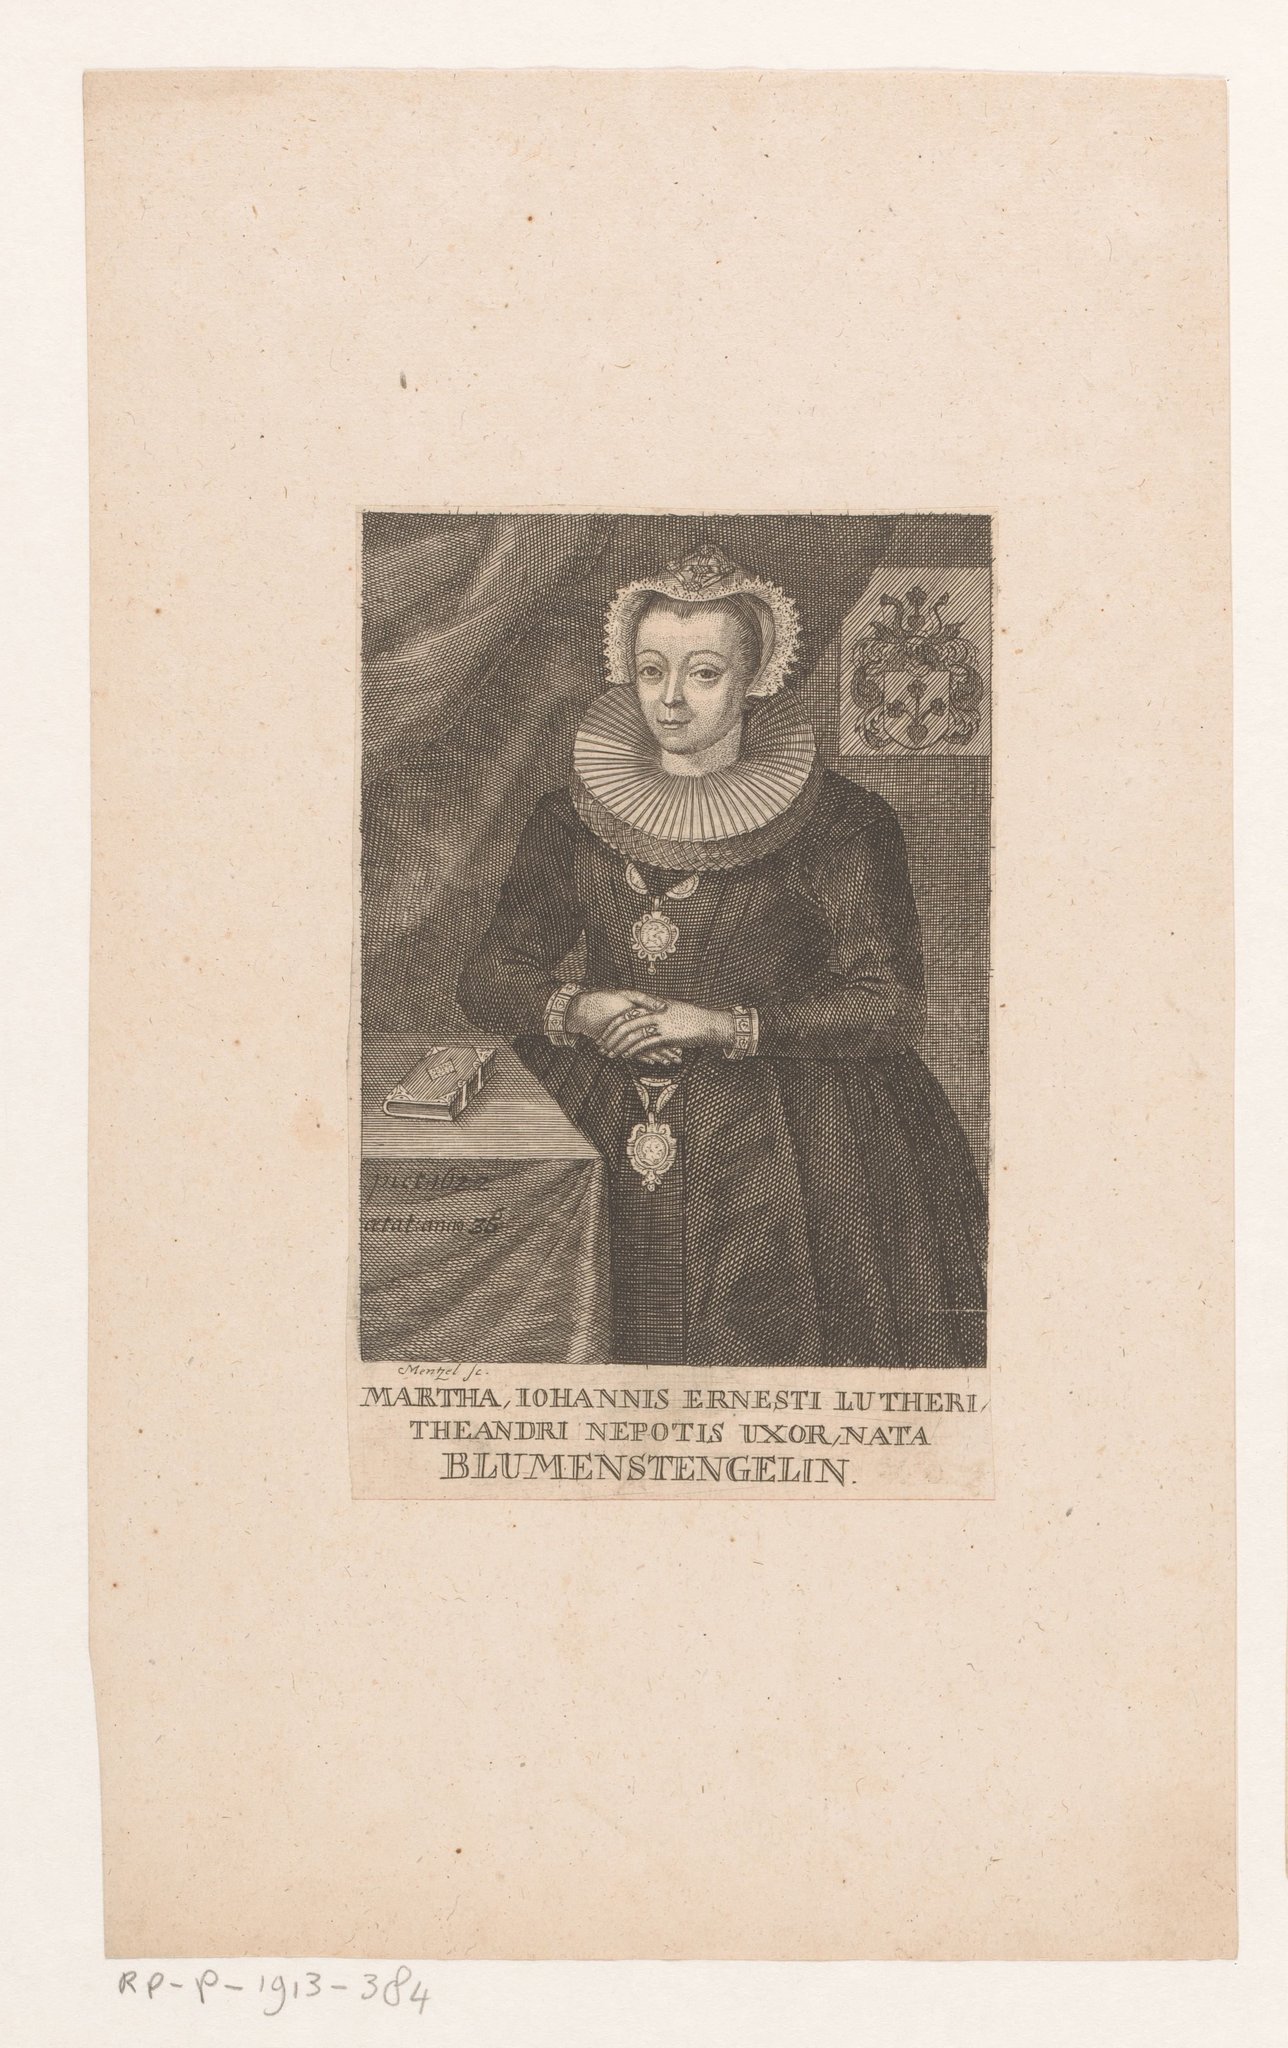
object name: print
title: Portret van Martha Luther-Blumenstengel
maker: johann georg mentzel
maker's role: print maker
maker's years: 1677-1743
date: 1733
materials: paper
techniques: engraving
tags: historical persons - bb - woman, pendant, trinket, 'breloque', book, armorial bearing, heraldry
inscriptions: collector's mark: Lugt 2228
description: Prent ook gebruikt in: Richter, David. Genealogia Lutherorum (...). Berlin/Leipzig: Johann Andreas Rüdiger, 1733.